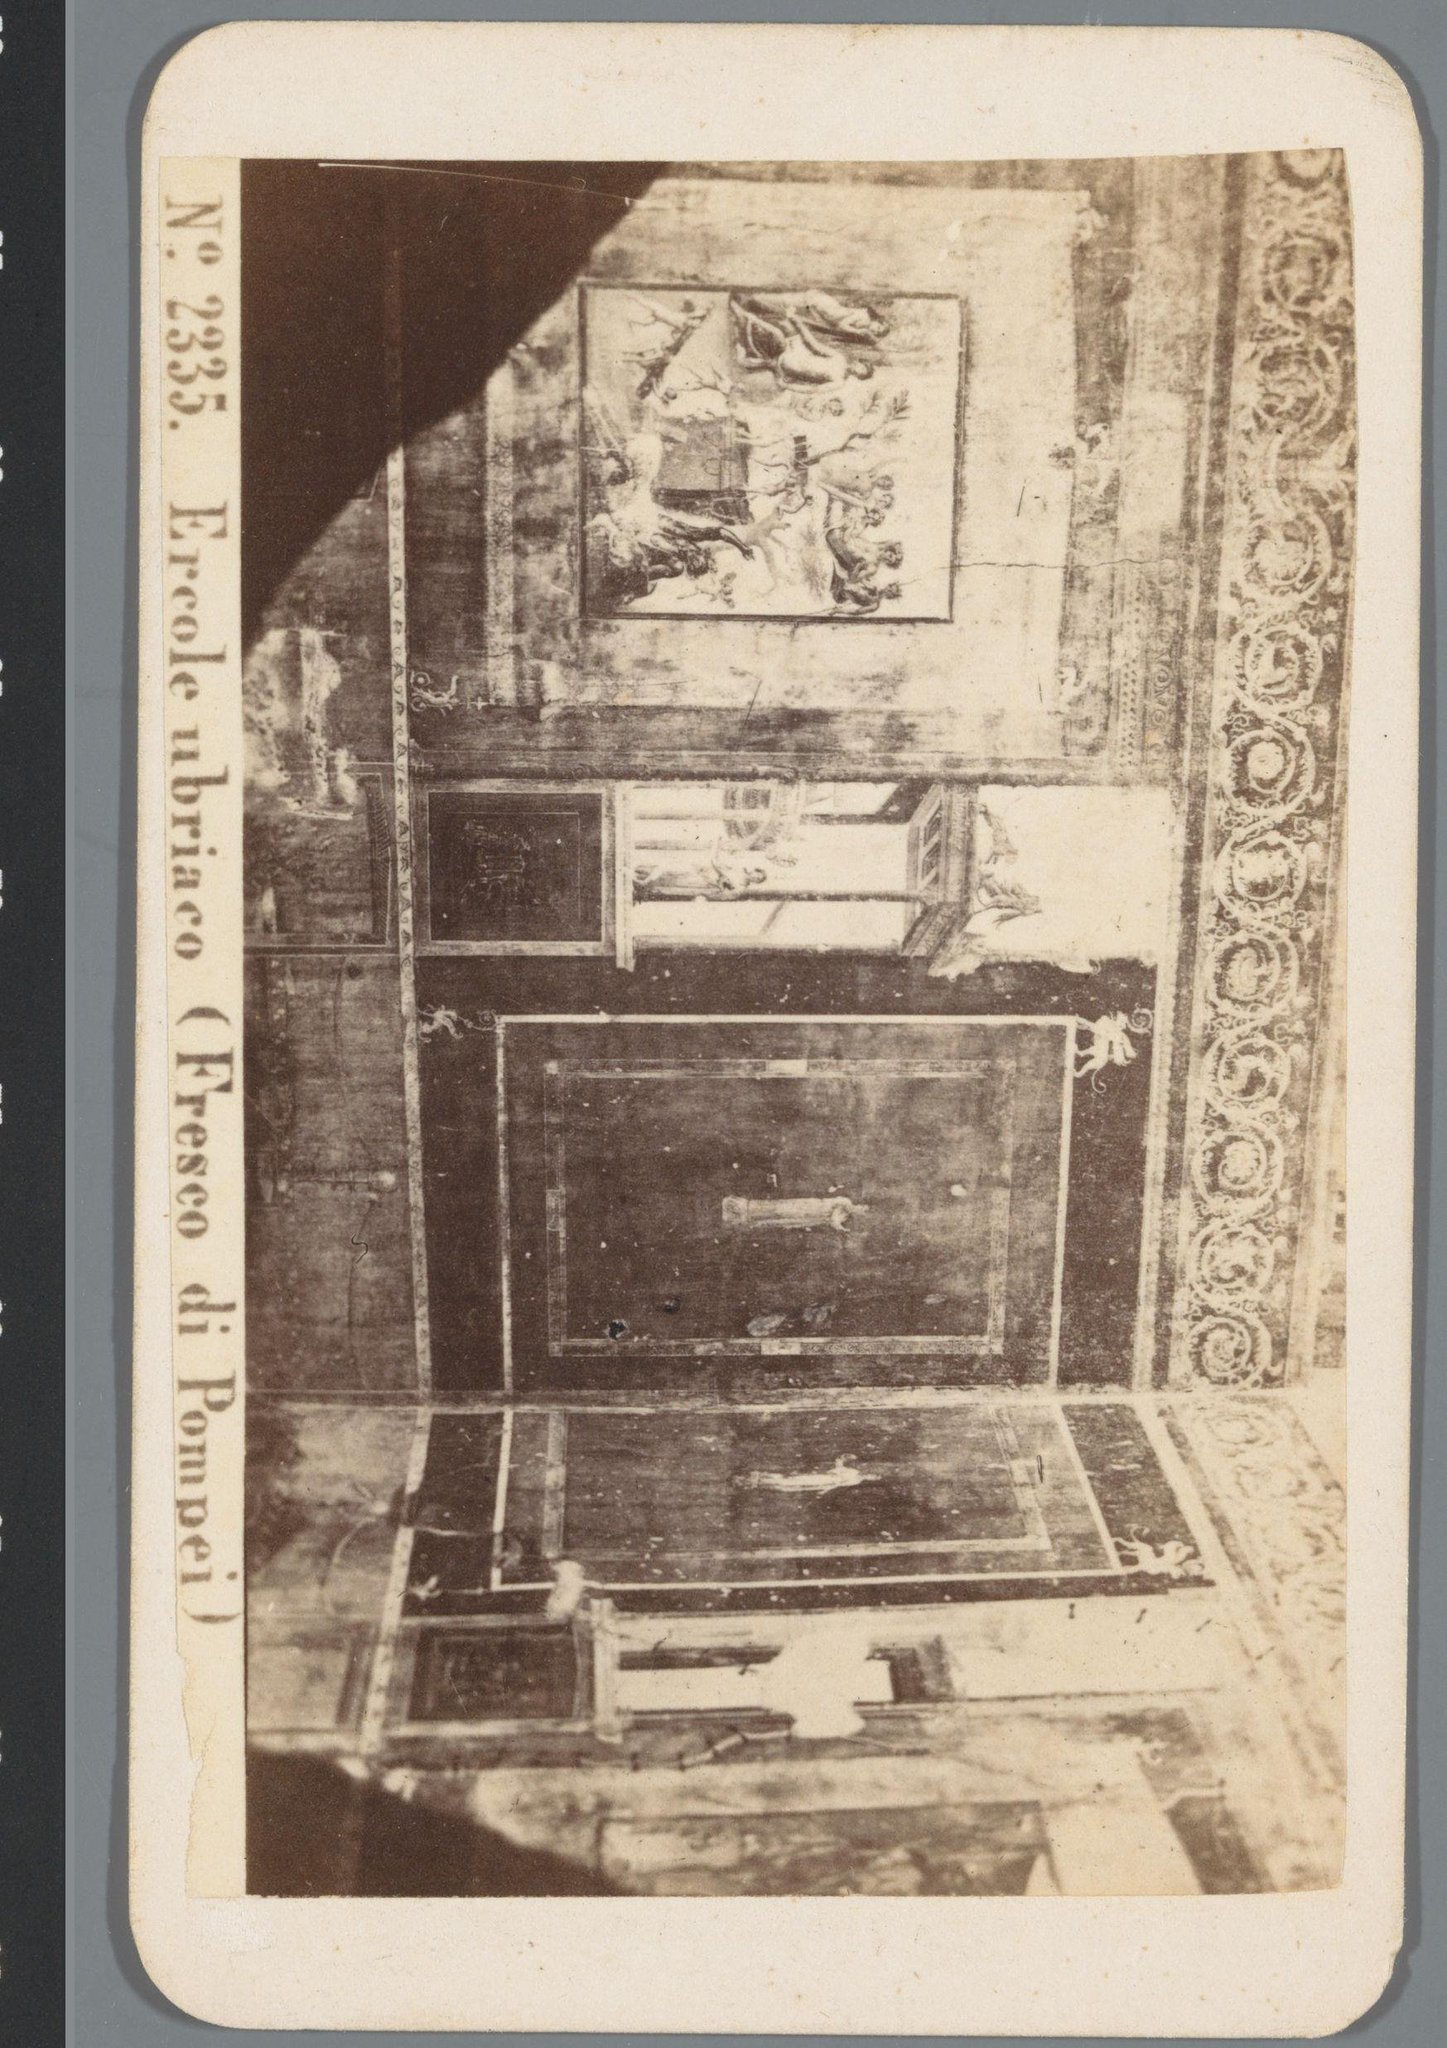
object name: photograph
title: Ercole ubriaco (Fresco di Pompei)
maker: giorgio sommer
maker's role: fotograaf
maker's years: 1834-1914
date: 1865-1888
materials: cardboard, paper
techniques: albumen print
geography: pompeii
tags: the drunken hercules, pompeii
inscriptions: inscription: ‘Grandes Médailles d'or/ Georges Sommer/ Photographe/ Naples/ Atelier Monte di Dio No. 4 au 1er/ Magasin Sta. Caterina No. 5./ Lit. Richter & Co.’, number: ‘No. 2335.’